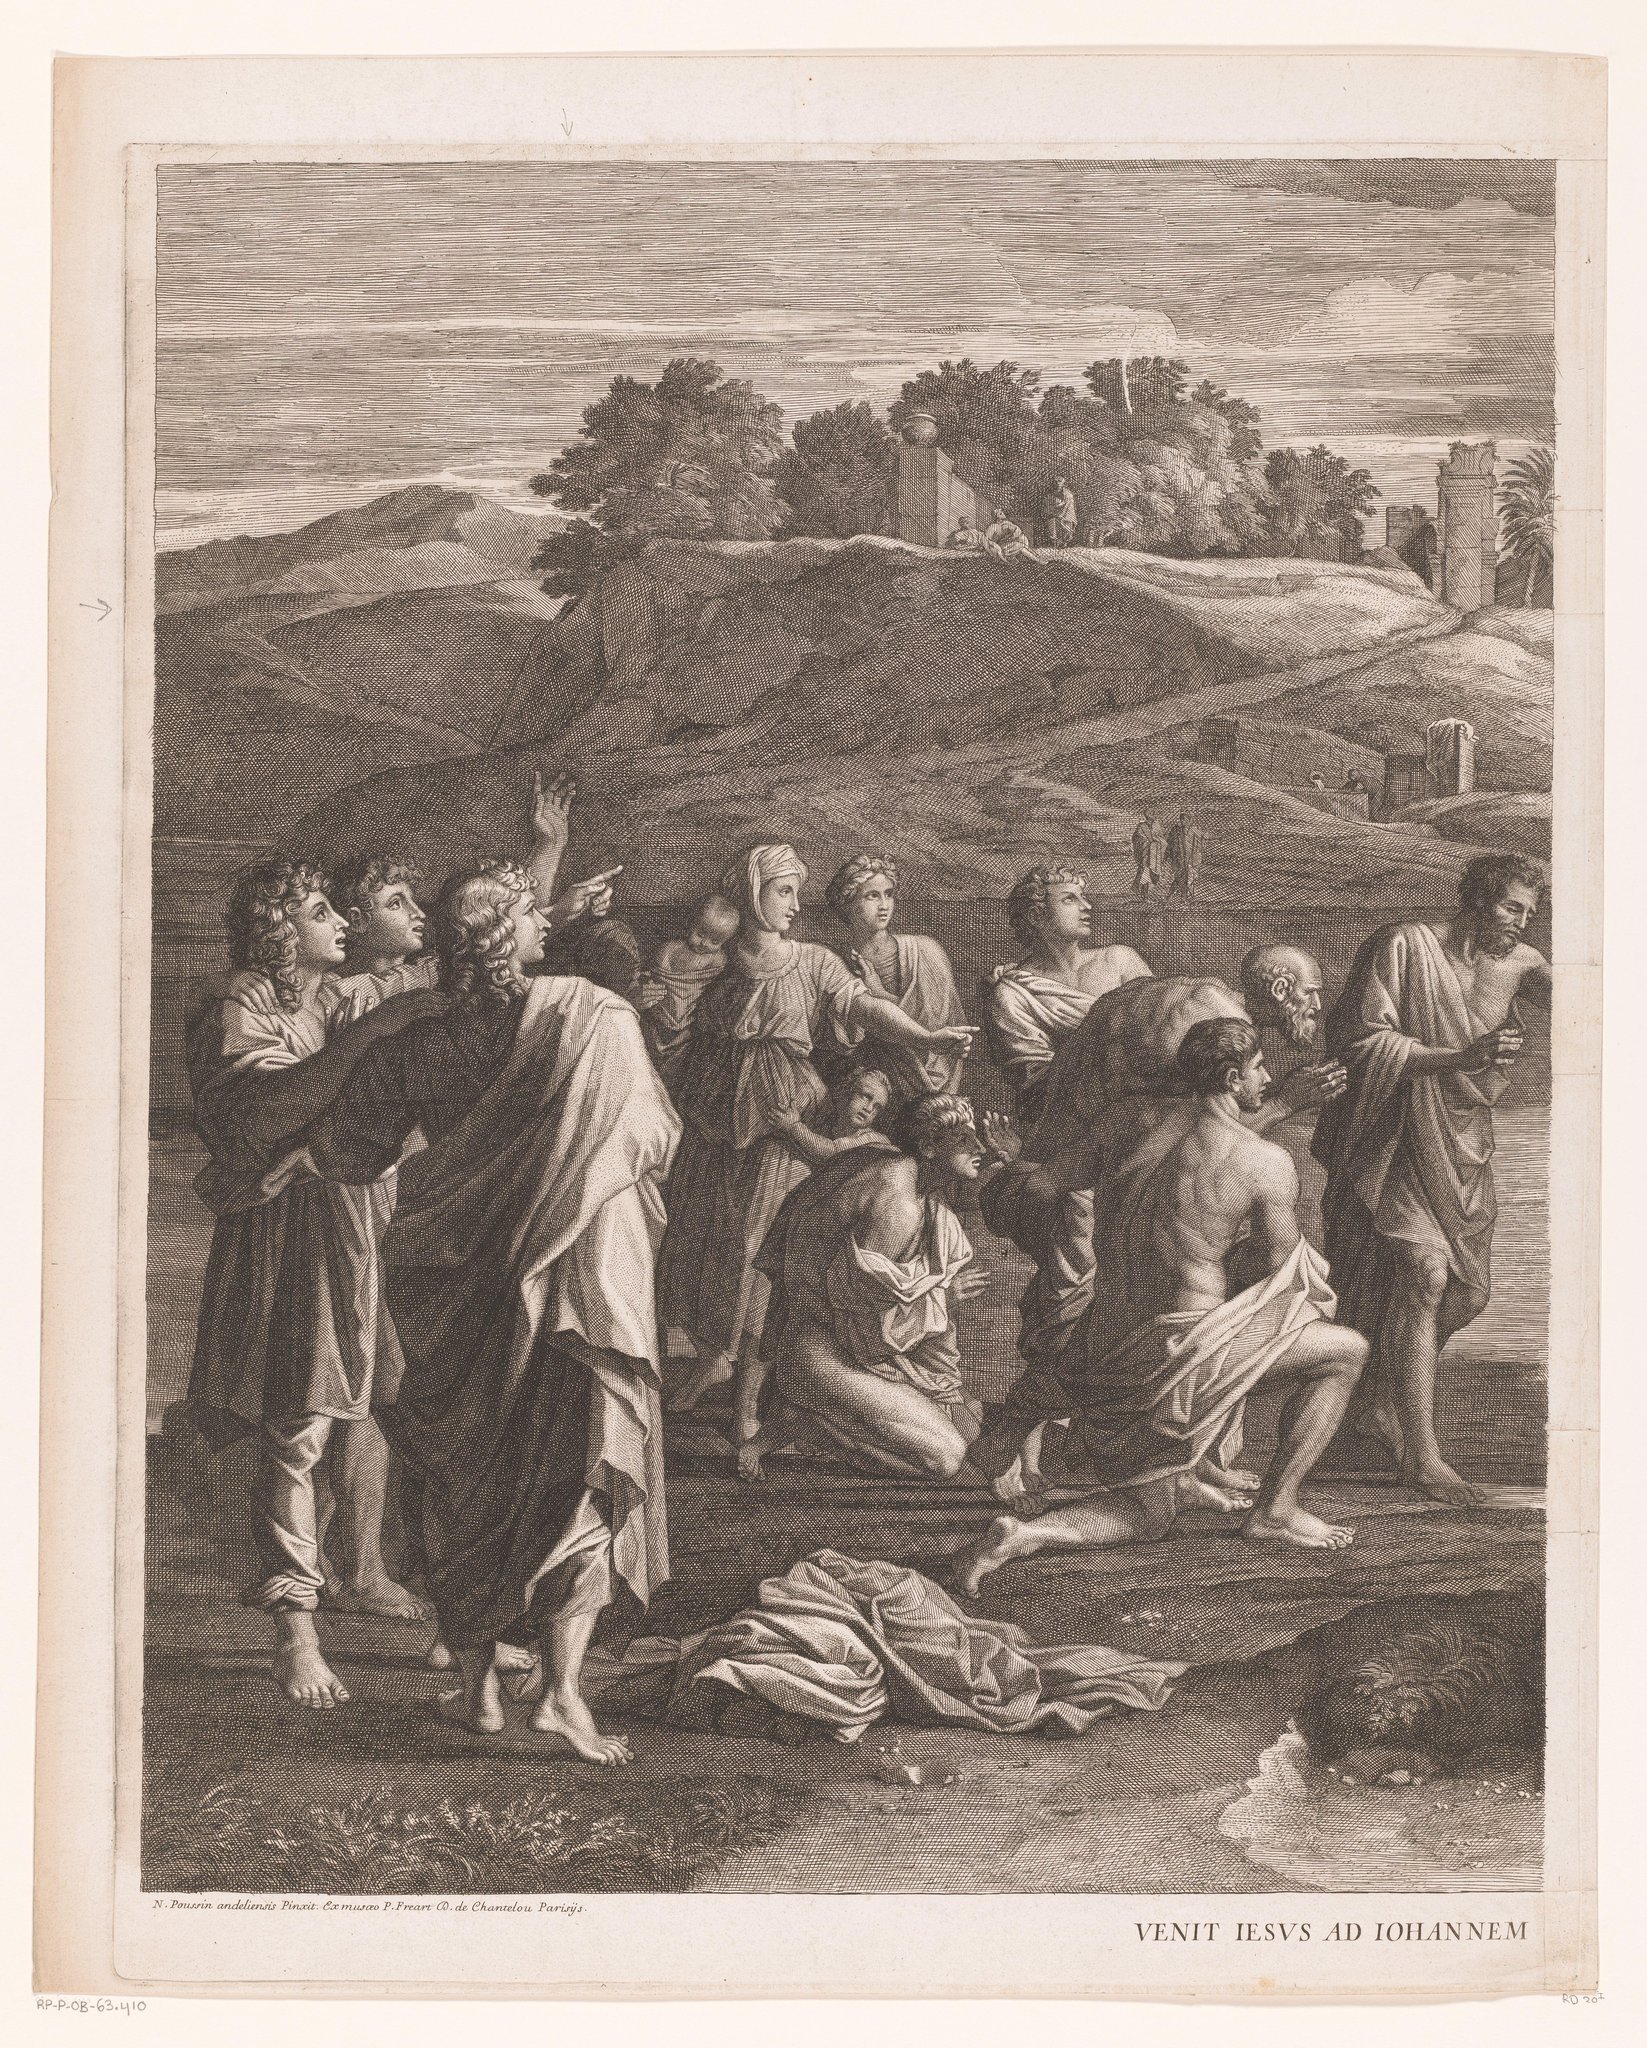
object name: print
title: Zeven sacramenten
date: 1633-1700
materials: paper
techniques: etching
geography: france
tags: baptism of christ in the river jordan: john the baptist pouring out water on christ's head: the holy ghost descends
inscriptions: collector's mark: Lugt 240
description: Prent maakt deel uit van een ongenummerde serie van zeven prenten.